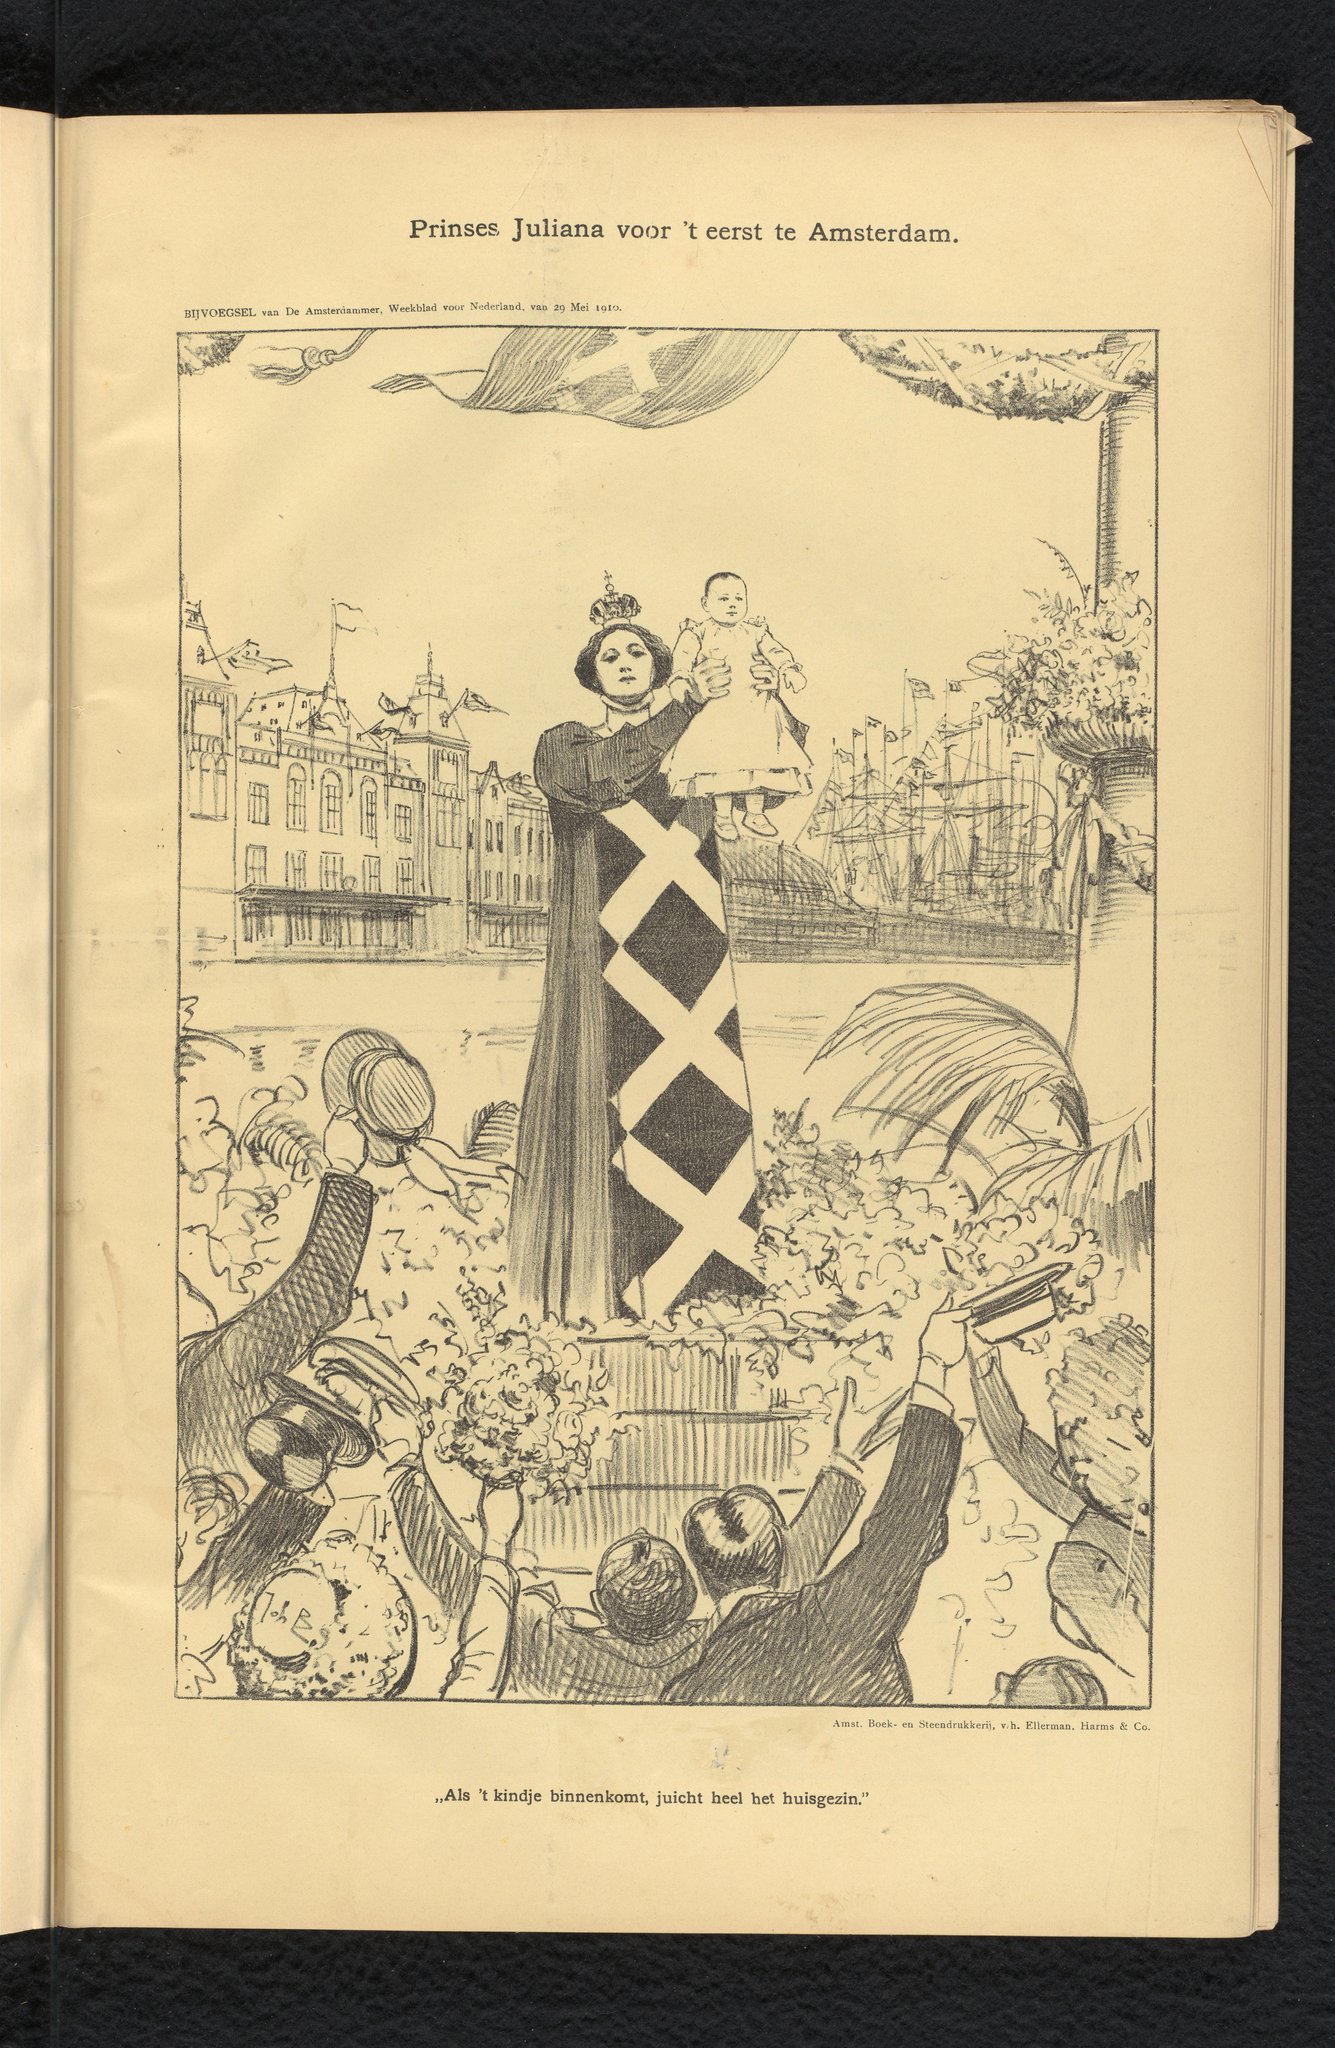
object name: cartoon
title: Prinses Juliana voor 't eerst te Amsterdam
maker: johan braakensiek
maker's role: draughtsman, print maker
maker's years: 1858-1940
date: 1910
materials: paper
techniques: lithograph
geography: netherlands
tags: the hague, juliana of the netherlands, personification of a city, town-patron(ess), crown princess - bb - female ruler, toddler (female), political caricatures and satires, amsterdam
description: De Amsterdamse stadsmaagd houdt het prinsesje Juliana omhoog voor een groep juichende Amsterdammers. Naar aanleiding van een eerste bezoek van de prinses aan Amsterdam.